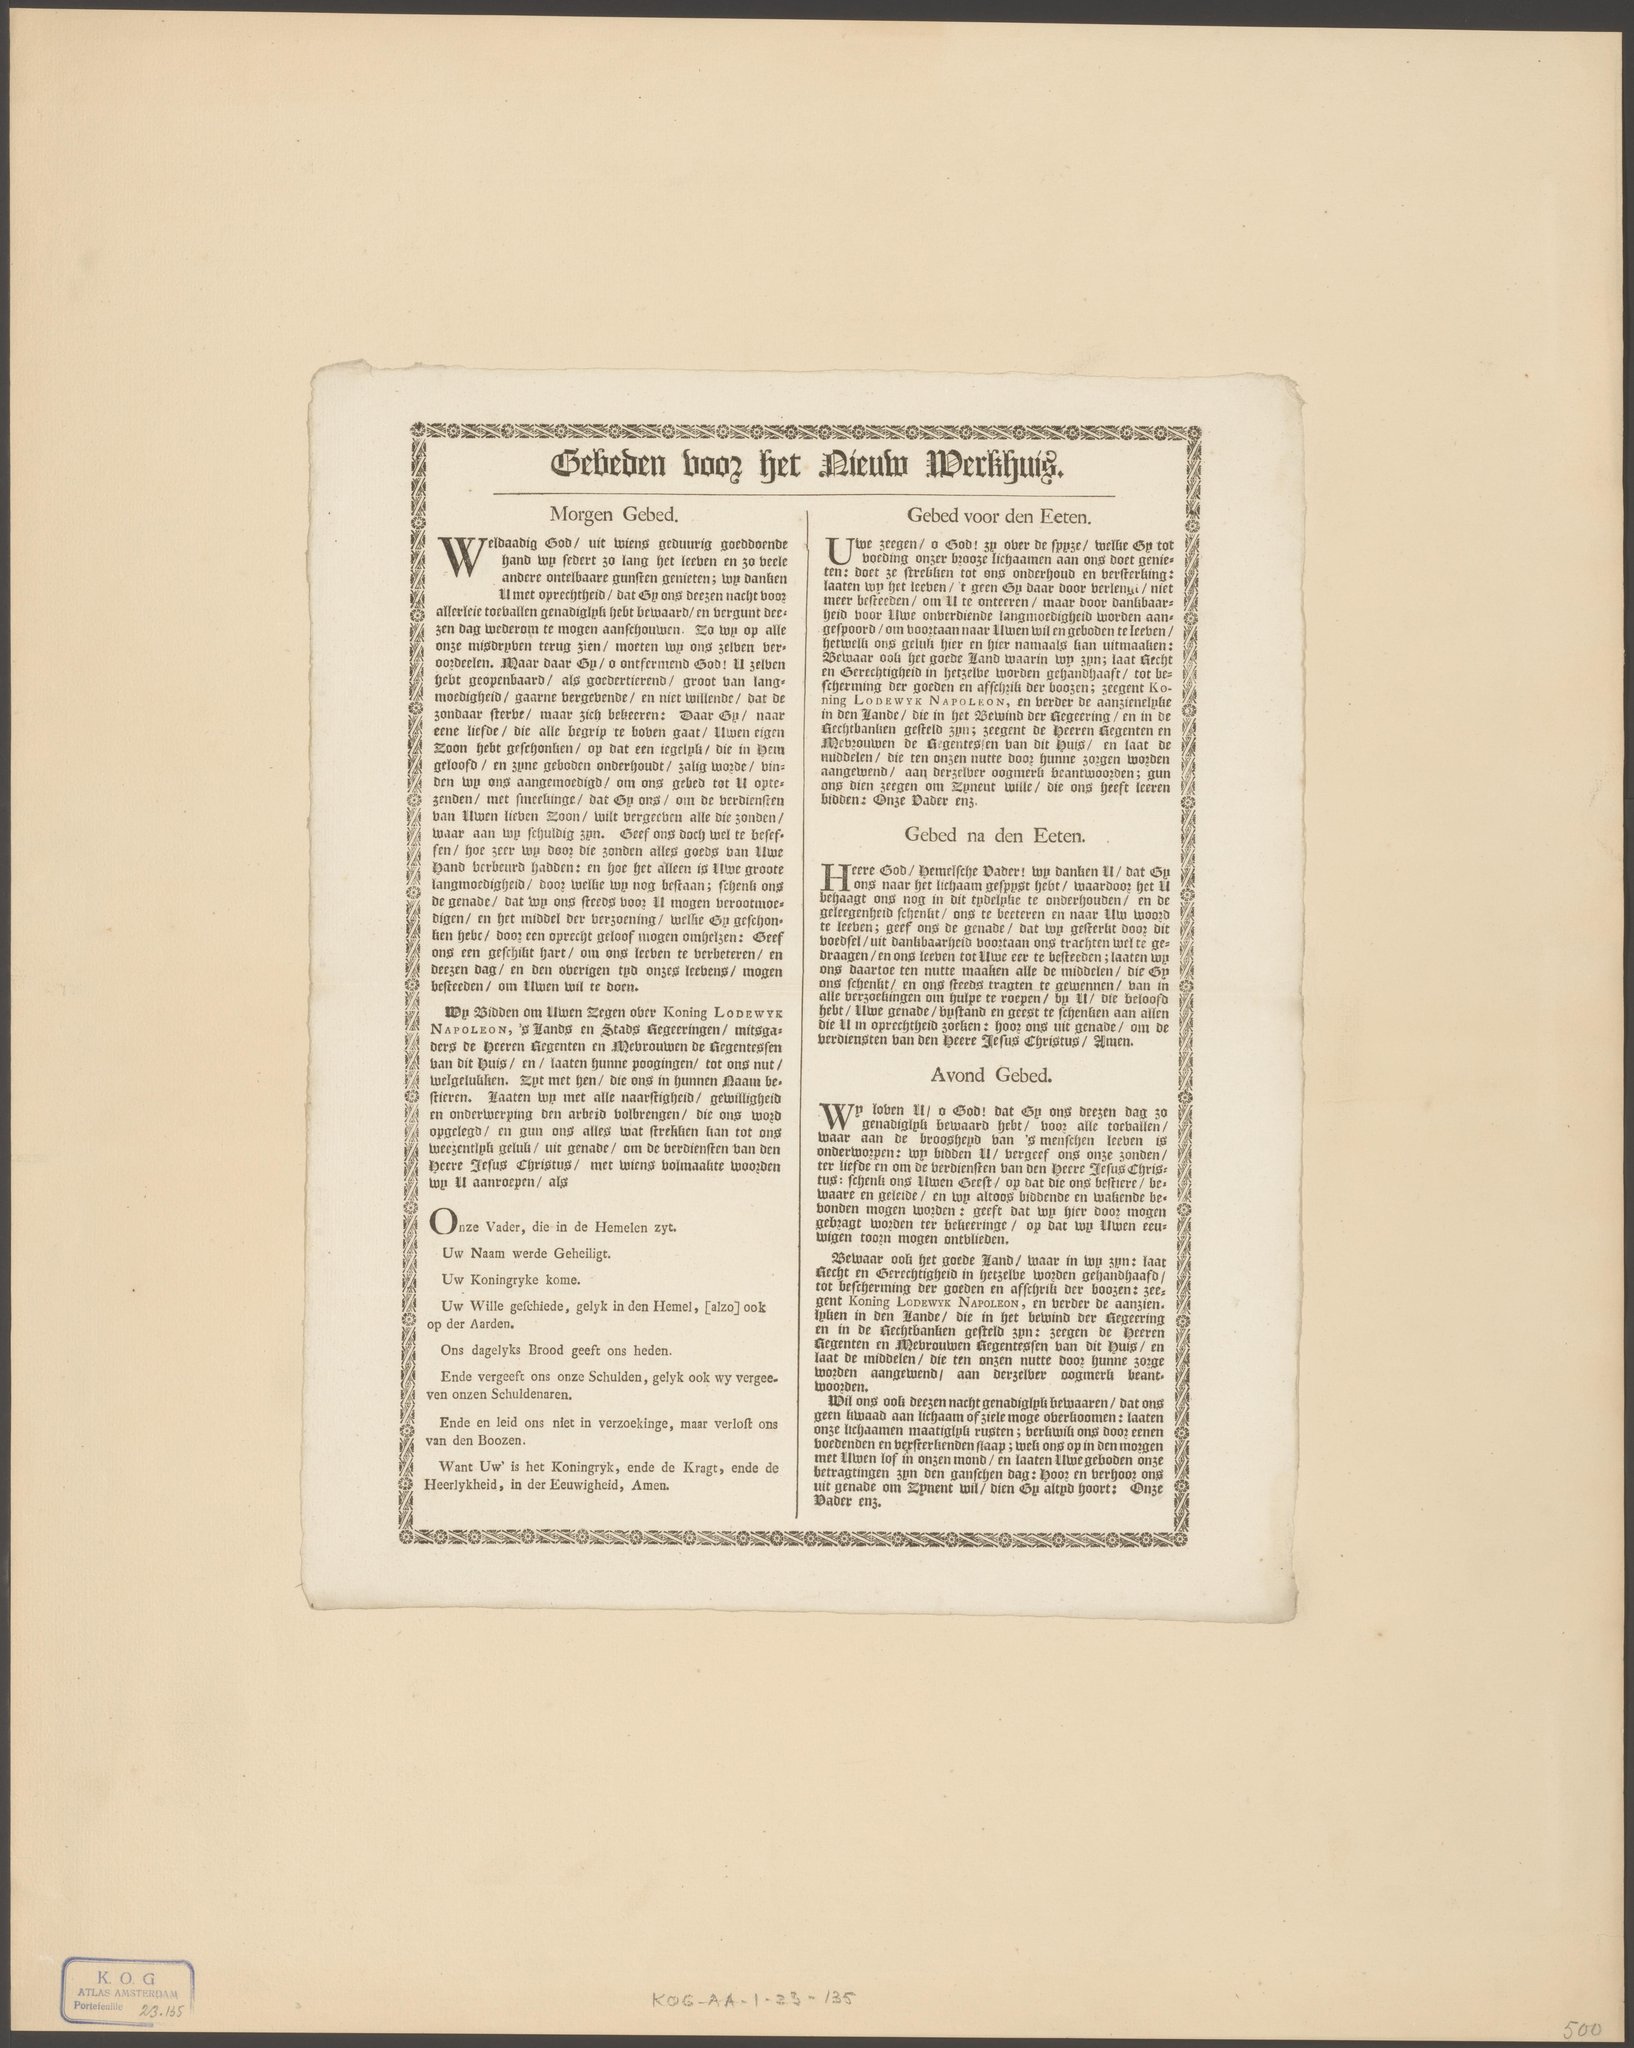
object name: text sheet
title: Gebeden voor het Nieuwe Werkhuis te Amsterdam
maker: Anonymous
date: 1806-1810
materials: paper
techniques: letterpress printing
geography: netherlands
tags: prison, jail, daily (vocal) prayer by one person, workhouse, penal camp, penitentiary, chain gang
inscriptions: collector's mark: Lugt 1641b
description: Onderwerpsrubriek binnen de Atlas Amsterdam: Rechtswezen.